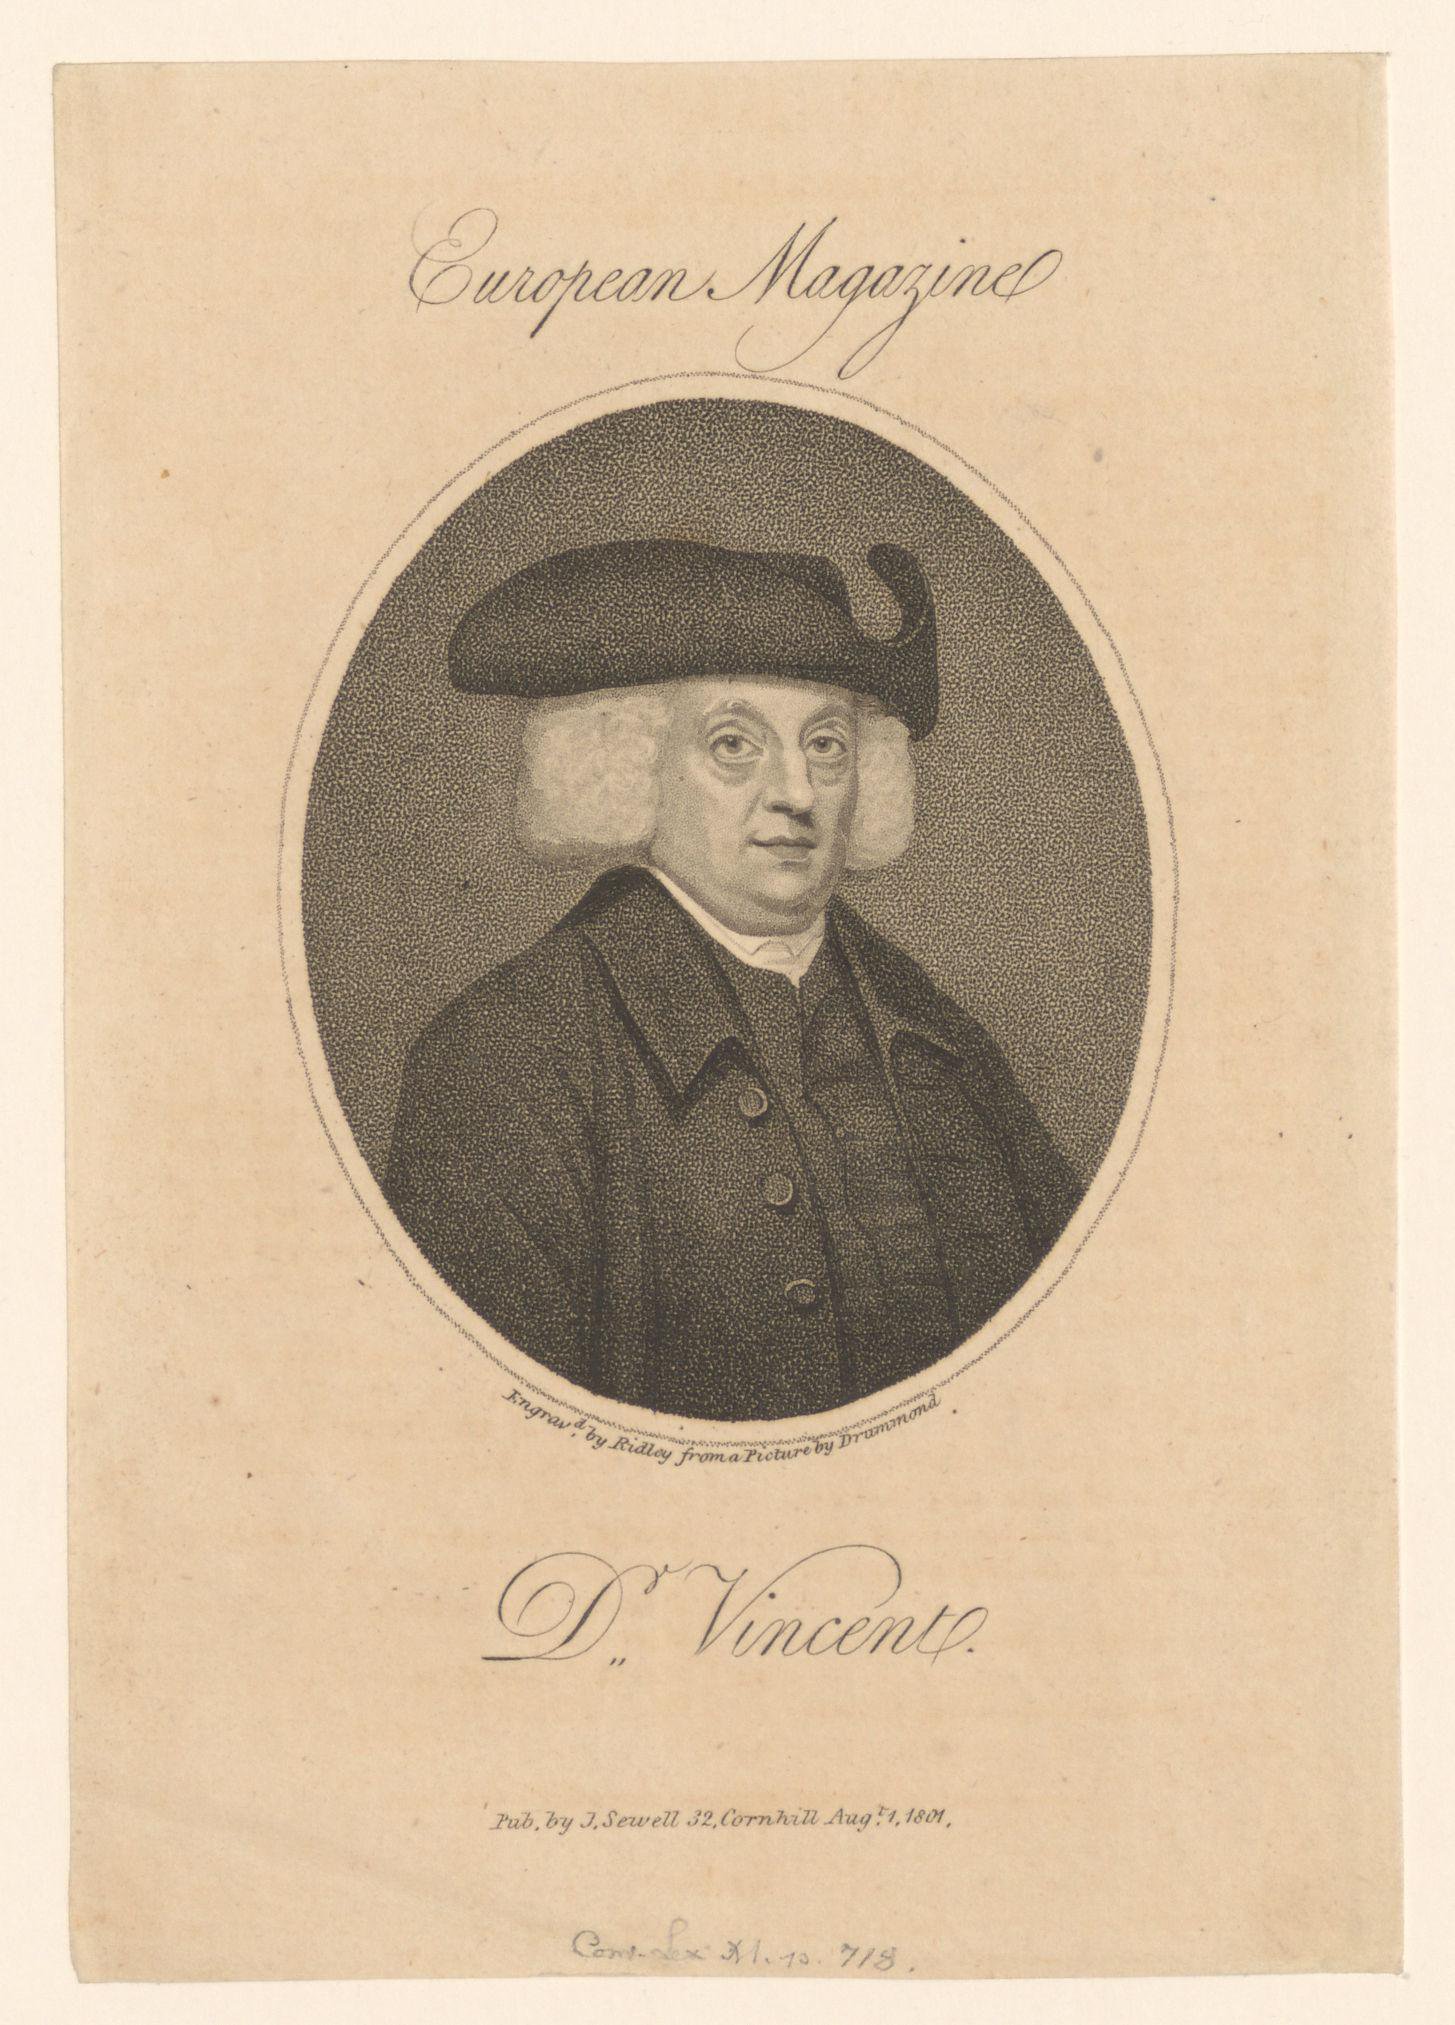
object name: print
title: Portret van William Vincent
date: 1801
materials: paper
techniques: stippling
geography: london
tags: theologian, historical persons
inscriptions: collector's mark: Lugt 2228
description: Prent gebruikt in: European Magazin (1801).